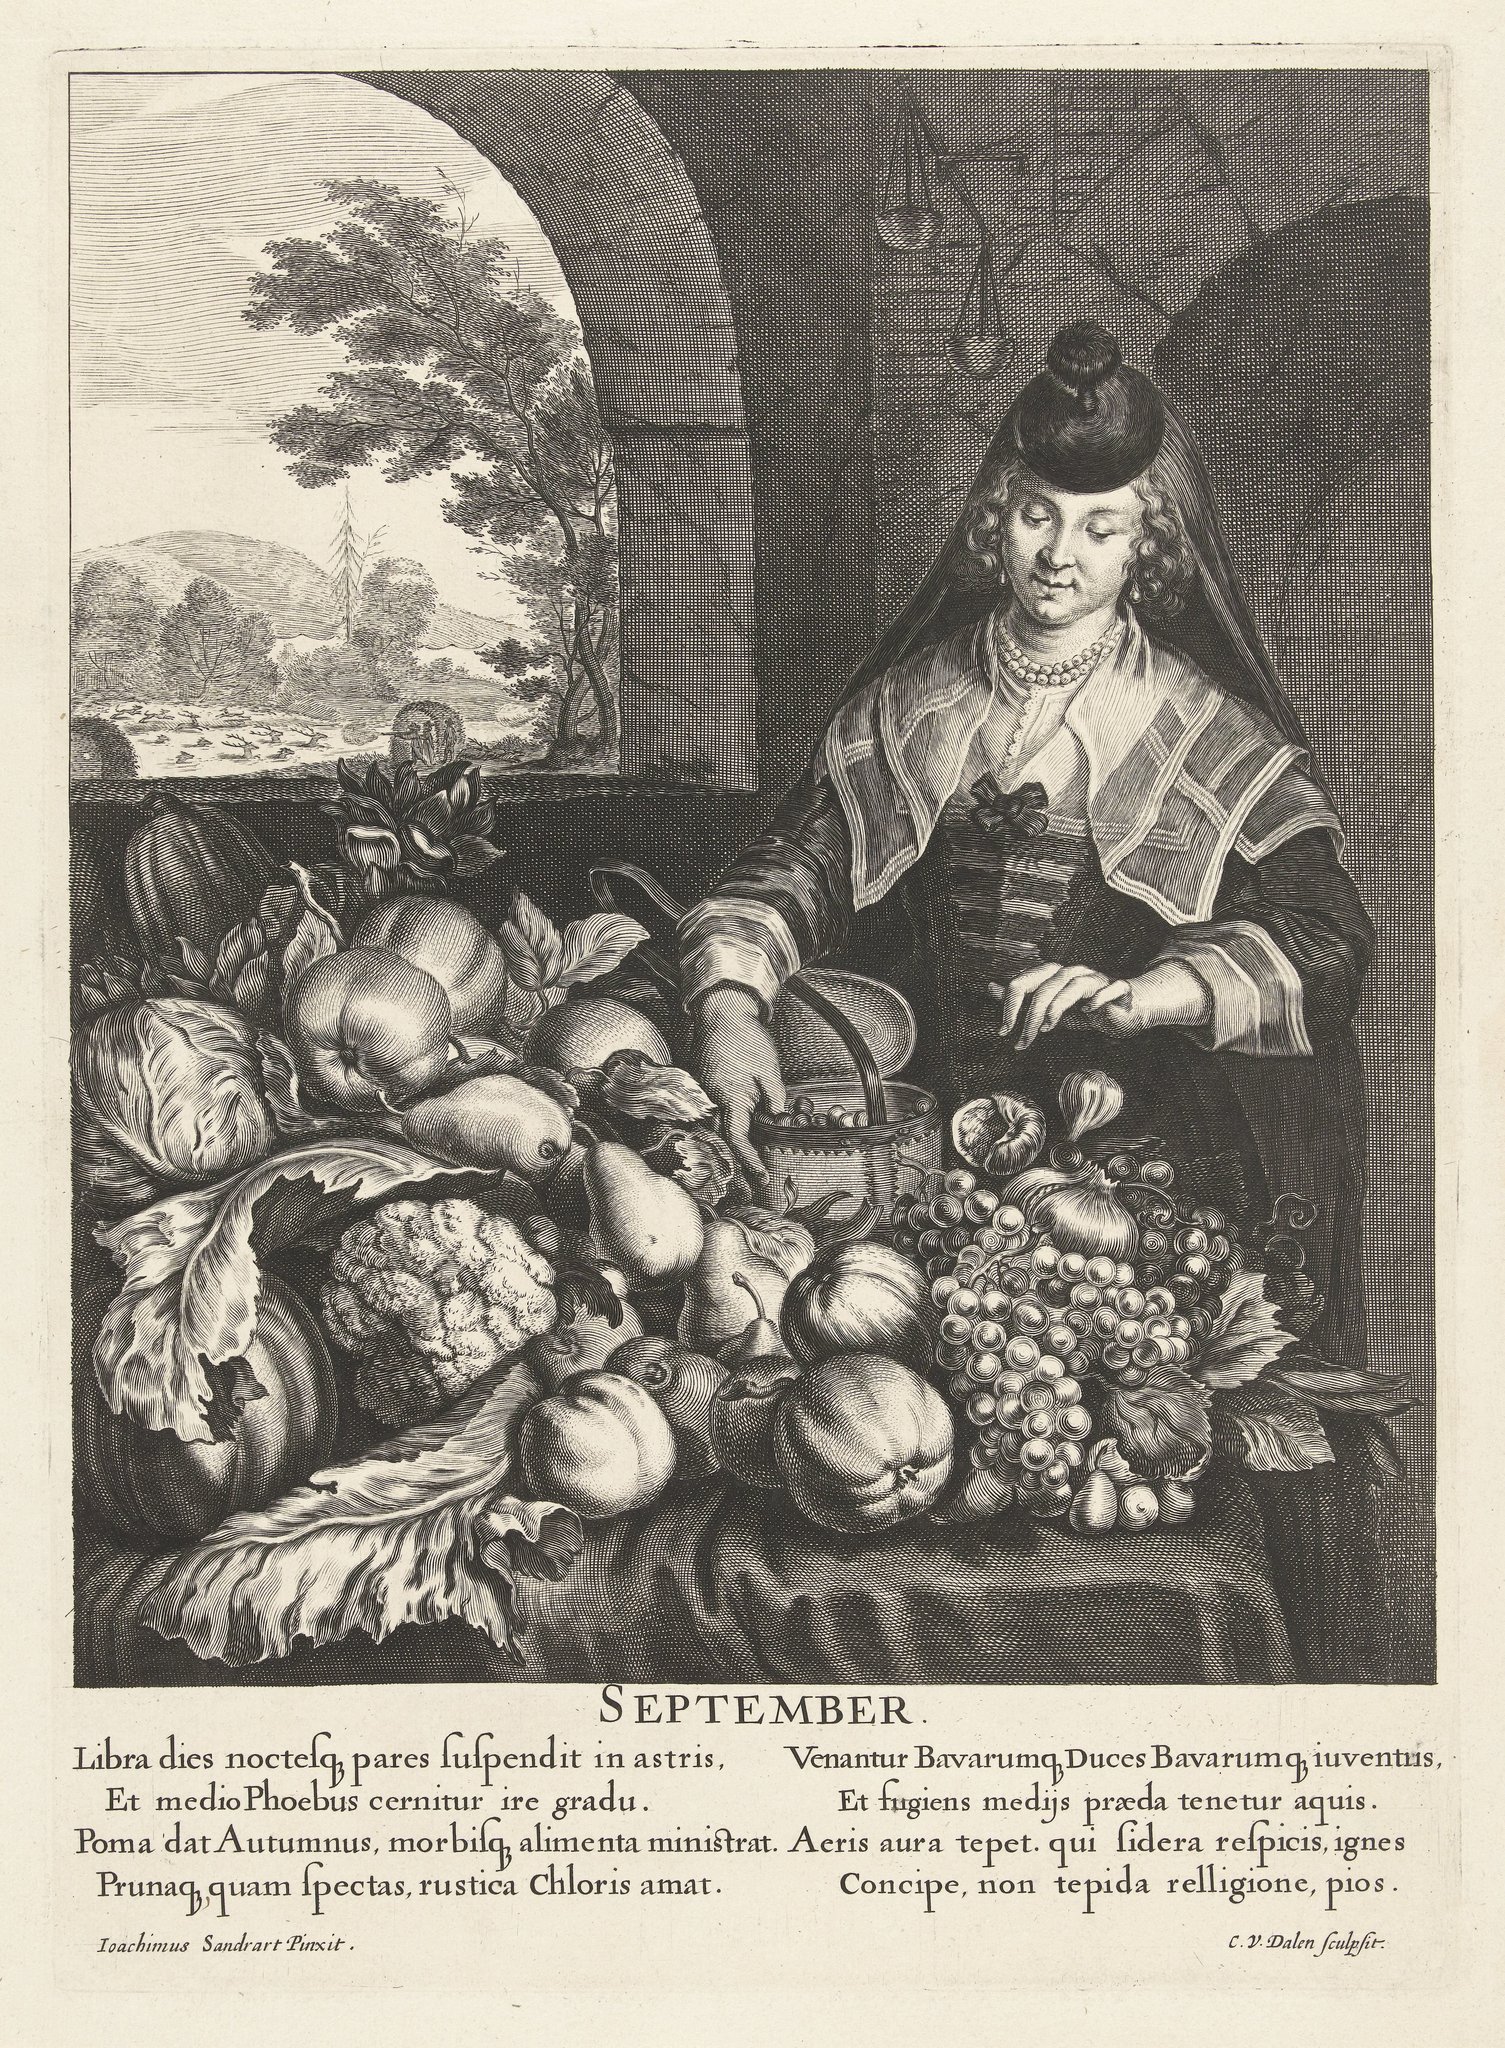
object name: print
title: September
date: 1645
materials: paper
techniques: engraving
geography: amsterdam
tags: vegetables and fruit; still life of vegetables and fruit, september ~ other concepts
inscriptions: collector's mark: Lugt 240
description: Joachim van Sandrart gaf de prenten naar zijn schilderijen van de twaalf maanden, de dag en de nacht, zelf uit in 1645. Zij werden vervaardigd door verschillende graveurs: Theodor Matham, Reinier van Persijn, Jonas Suyderhoef, Jeremias Falck, Cornelis van Dalen (II) en Albert Haelwegh.